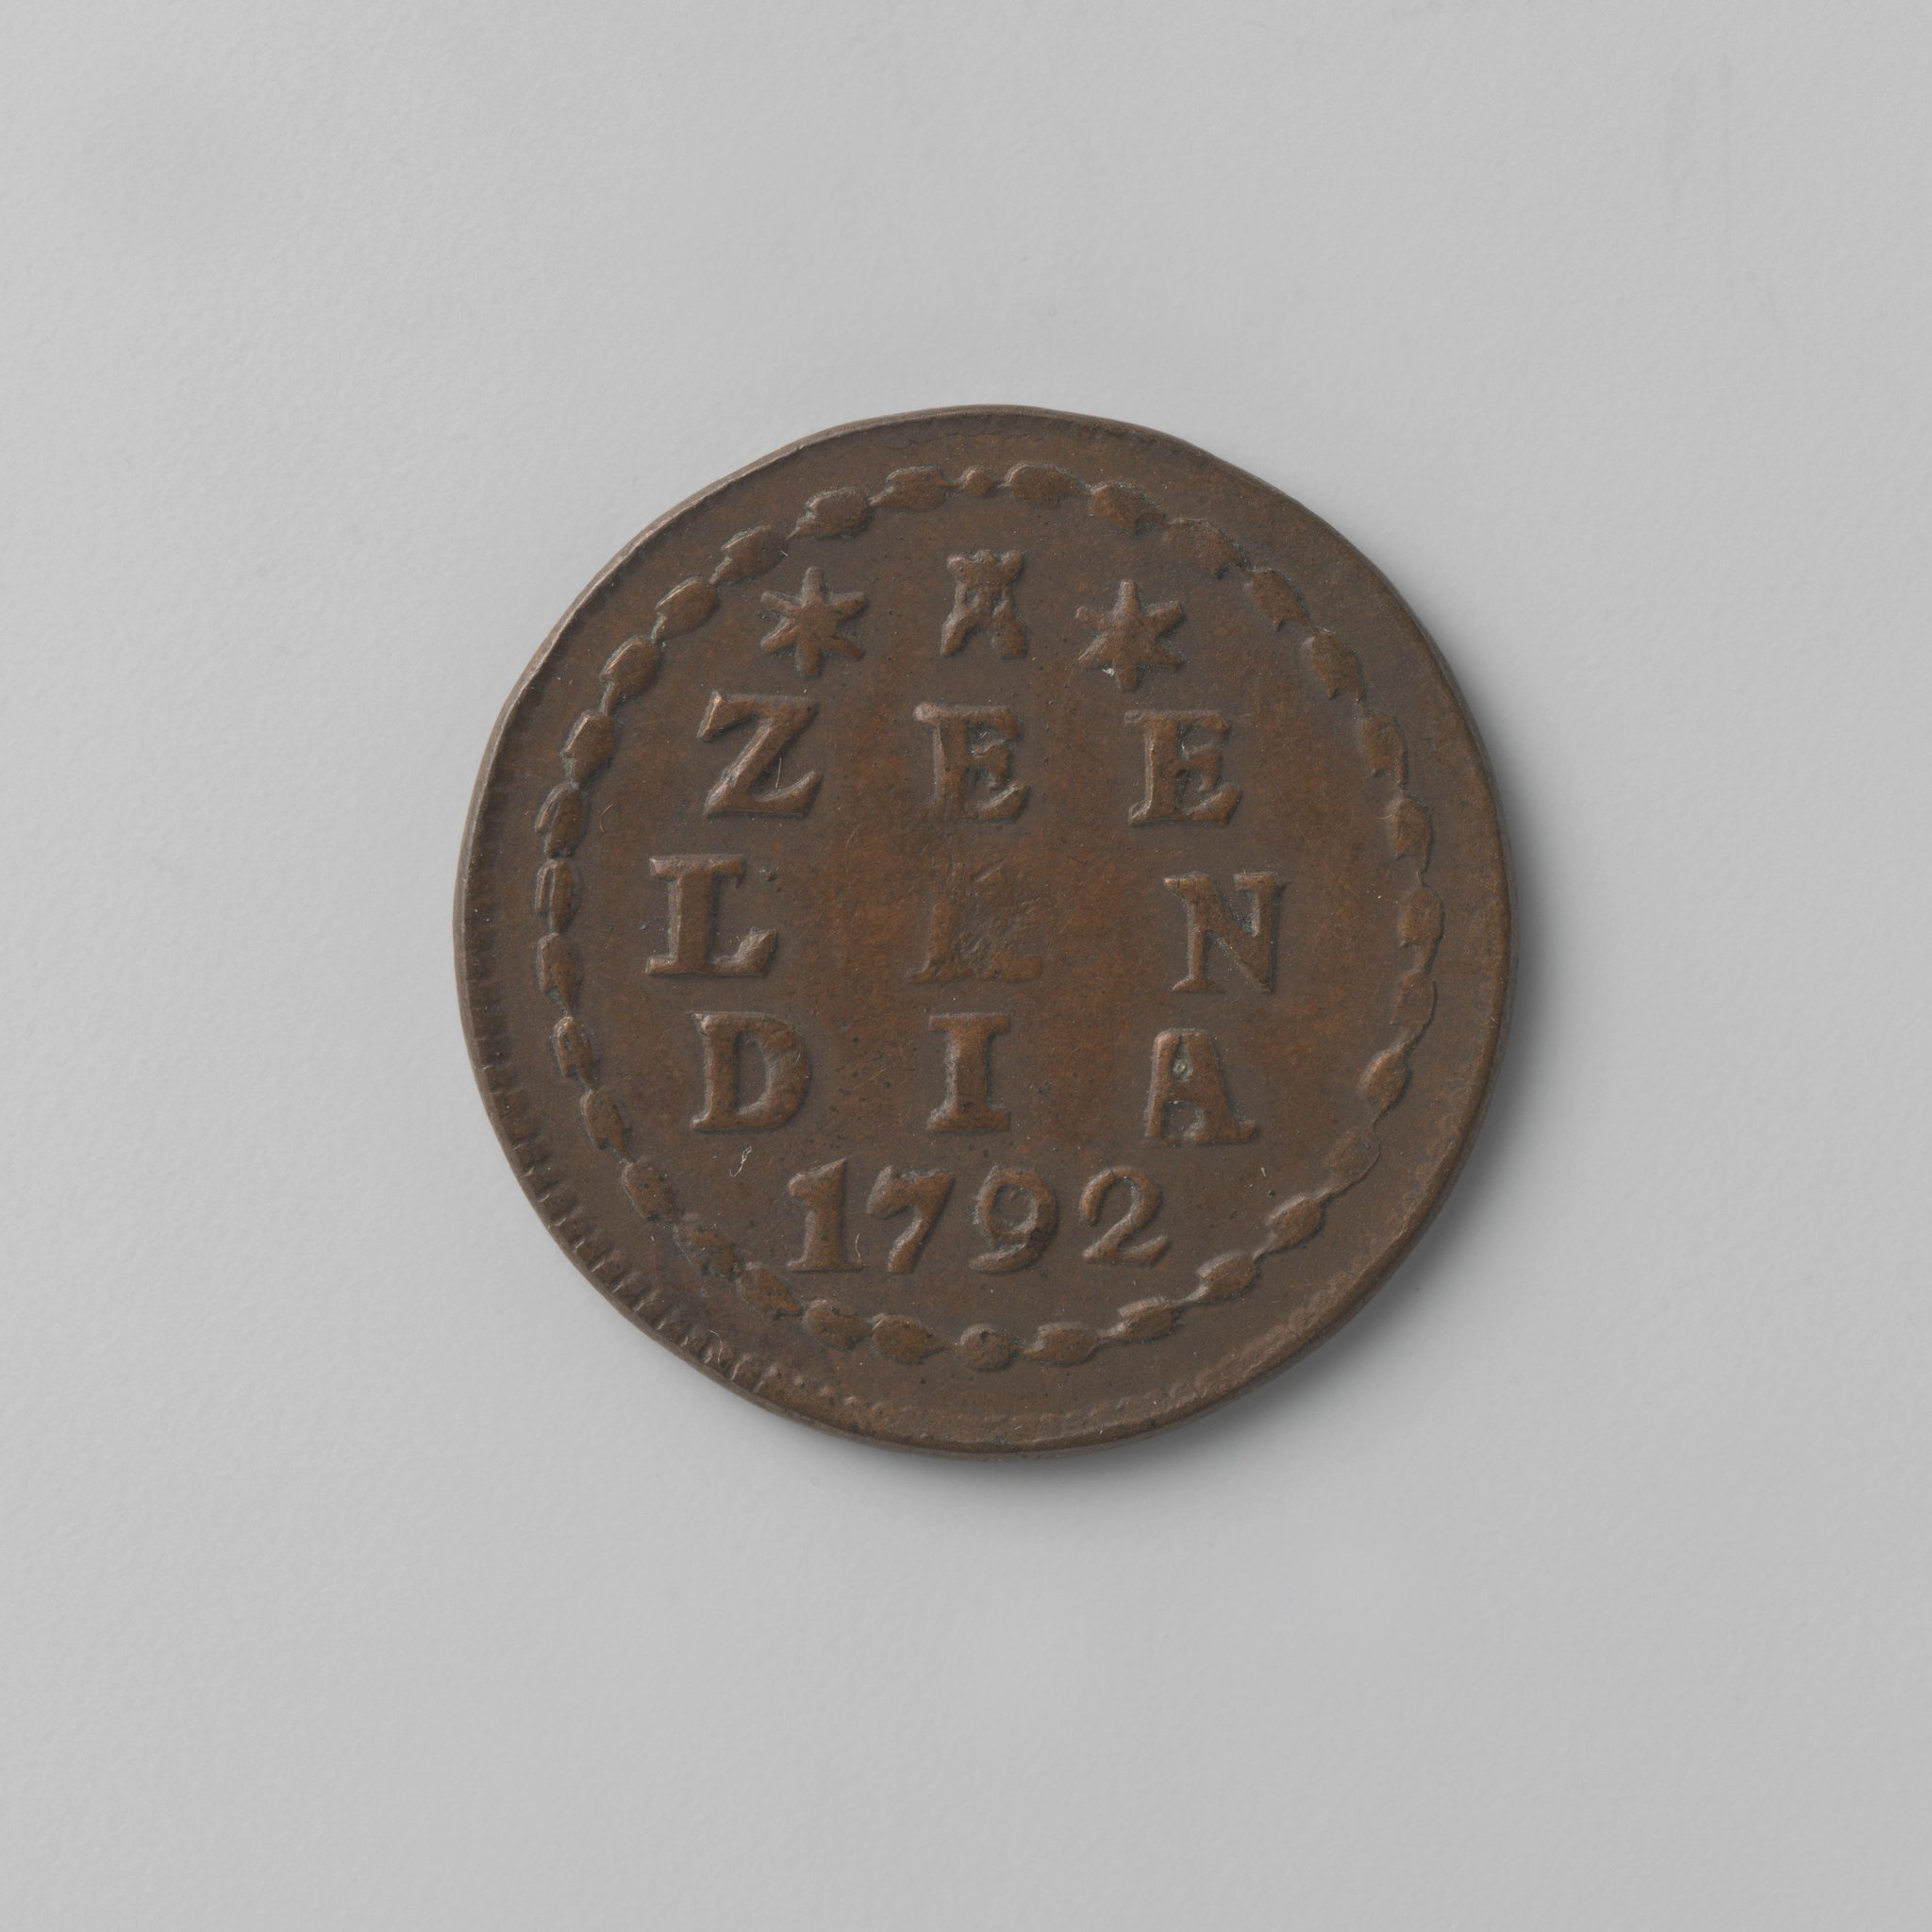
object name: coin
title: Zeeland, duit, 1792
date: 1792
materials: copper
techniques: striking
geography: middelburg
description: Koperen munt. Voorzijde: gekroond, zijdelings ingedeukt wapenschild van Zeeland. Keerzijde: in een krans opschrift in drie regels, waarboven muntteken burcht tussen twee sterren en waaronder jaartal.